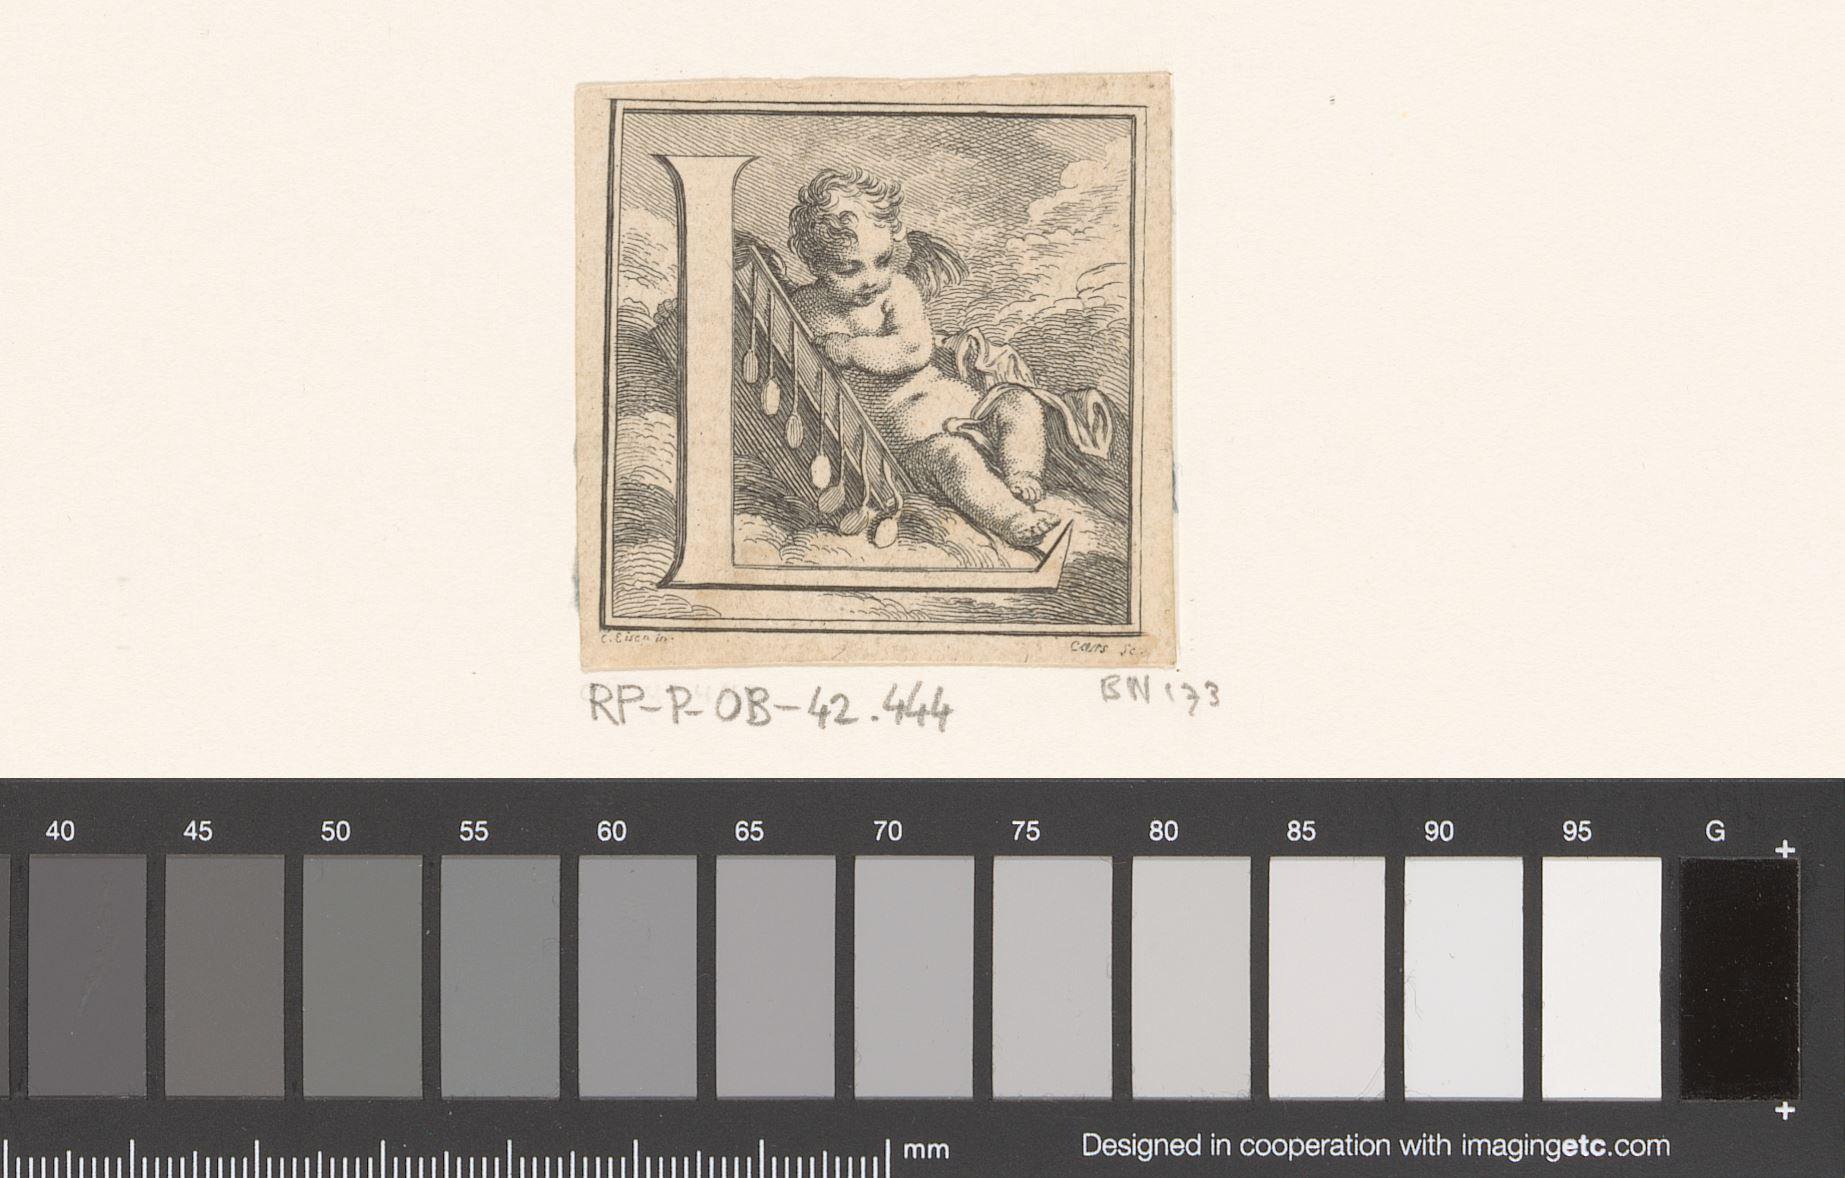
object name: book illustration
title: Hoofdletter L met een engel met een boek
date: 1760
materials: paper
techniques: etching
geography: france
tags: initial, book, cupids: 'amores', 'amoretti', 'putti'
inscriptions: collector's mark: Lugt 2228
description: Prent uit: Sibert, Gautier de. Catalogue des Chevaliers, Commandeurs et Officiers de l'ordre du Saint-Esprit. Parijs: C.J.F. Baltard, 1760.